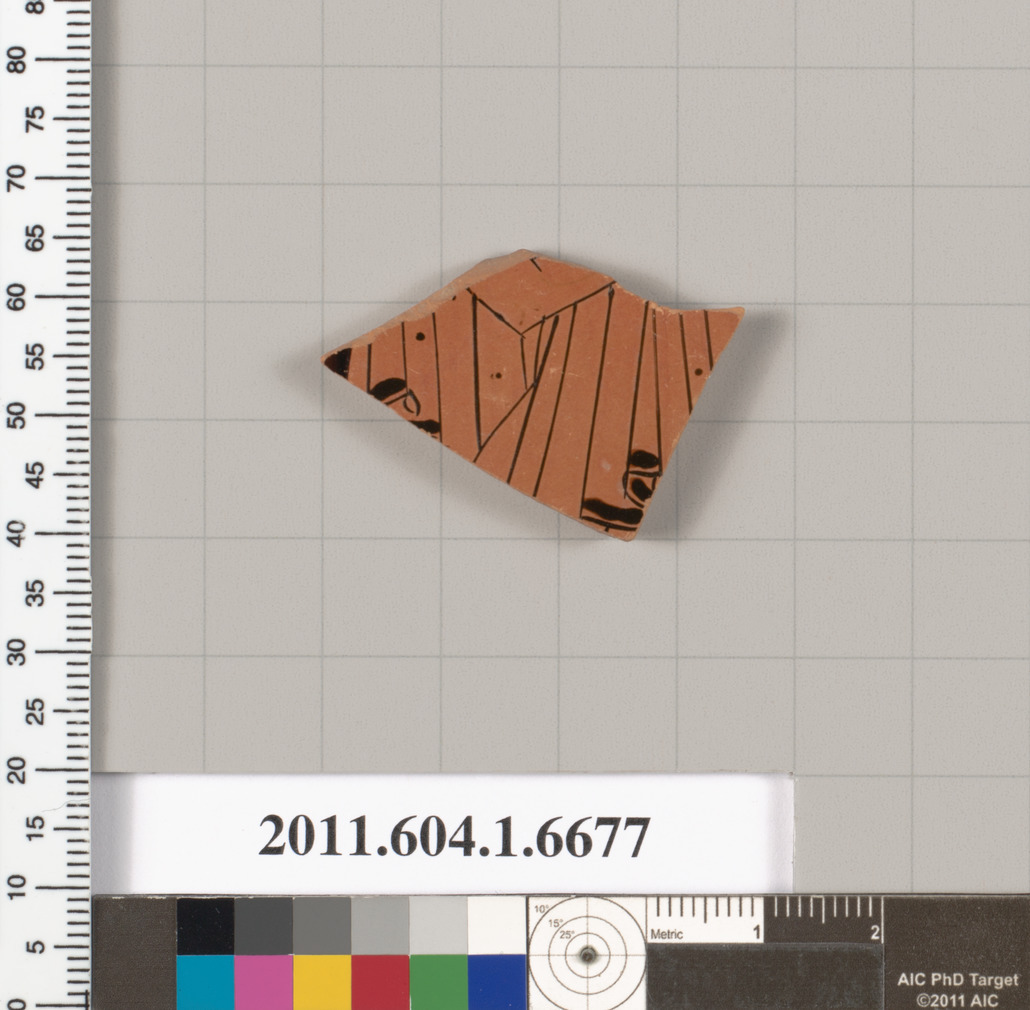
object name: kylix fragment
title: Terracotta fragment of a kylix (drinking cup)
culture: greek, attic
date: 490-470 BCE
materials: terracotta